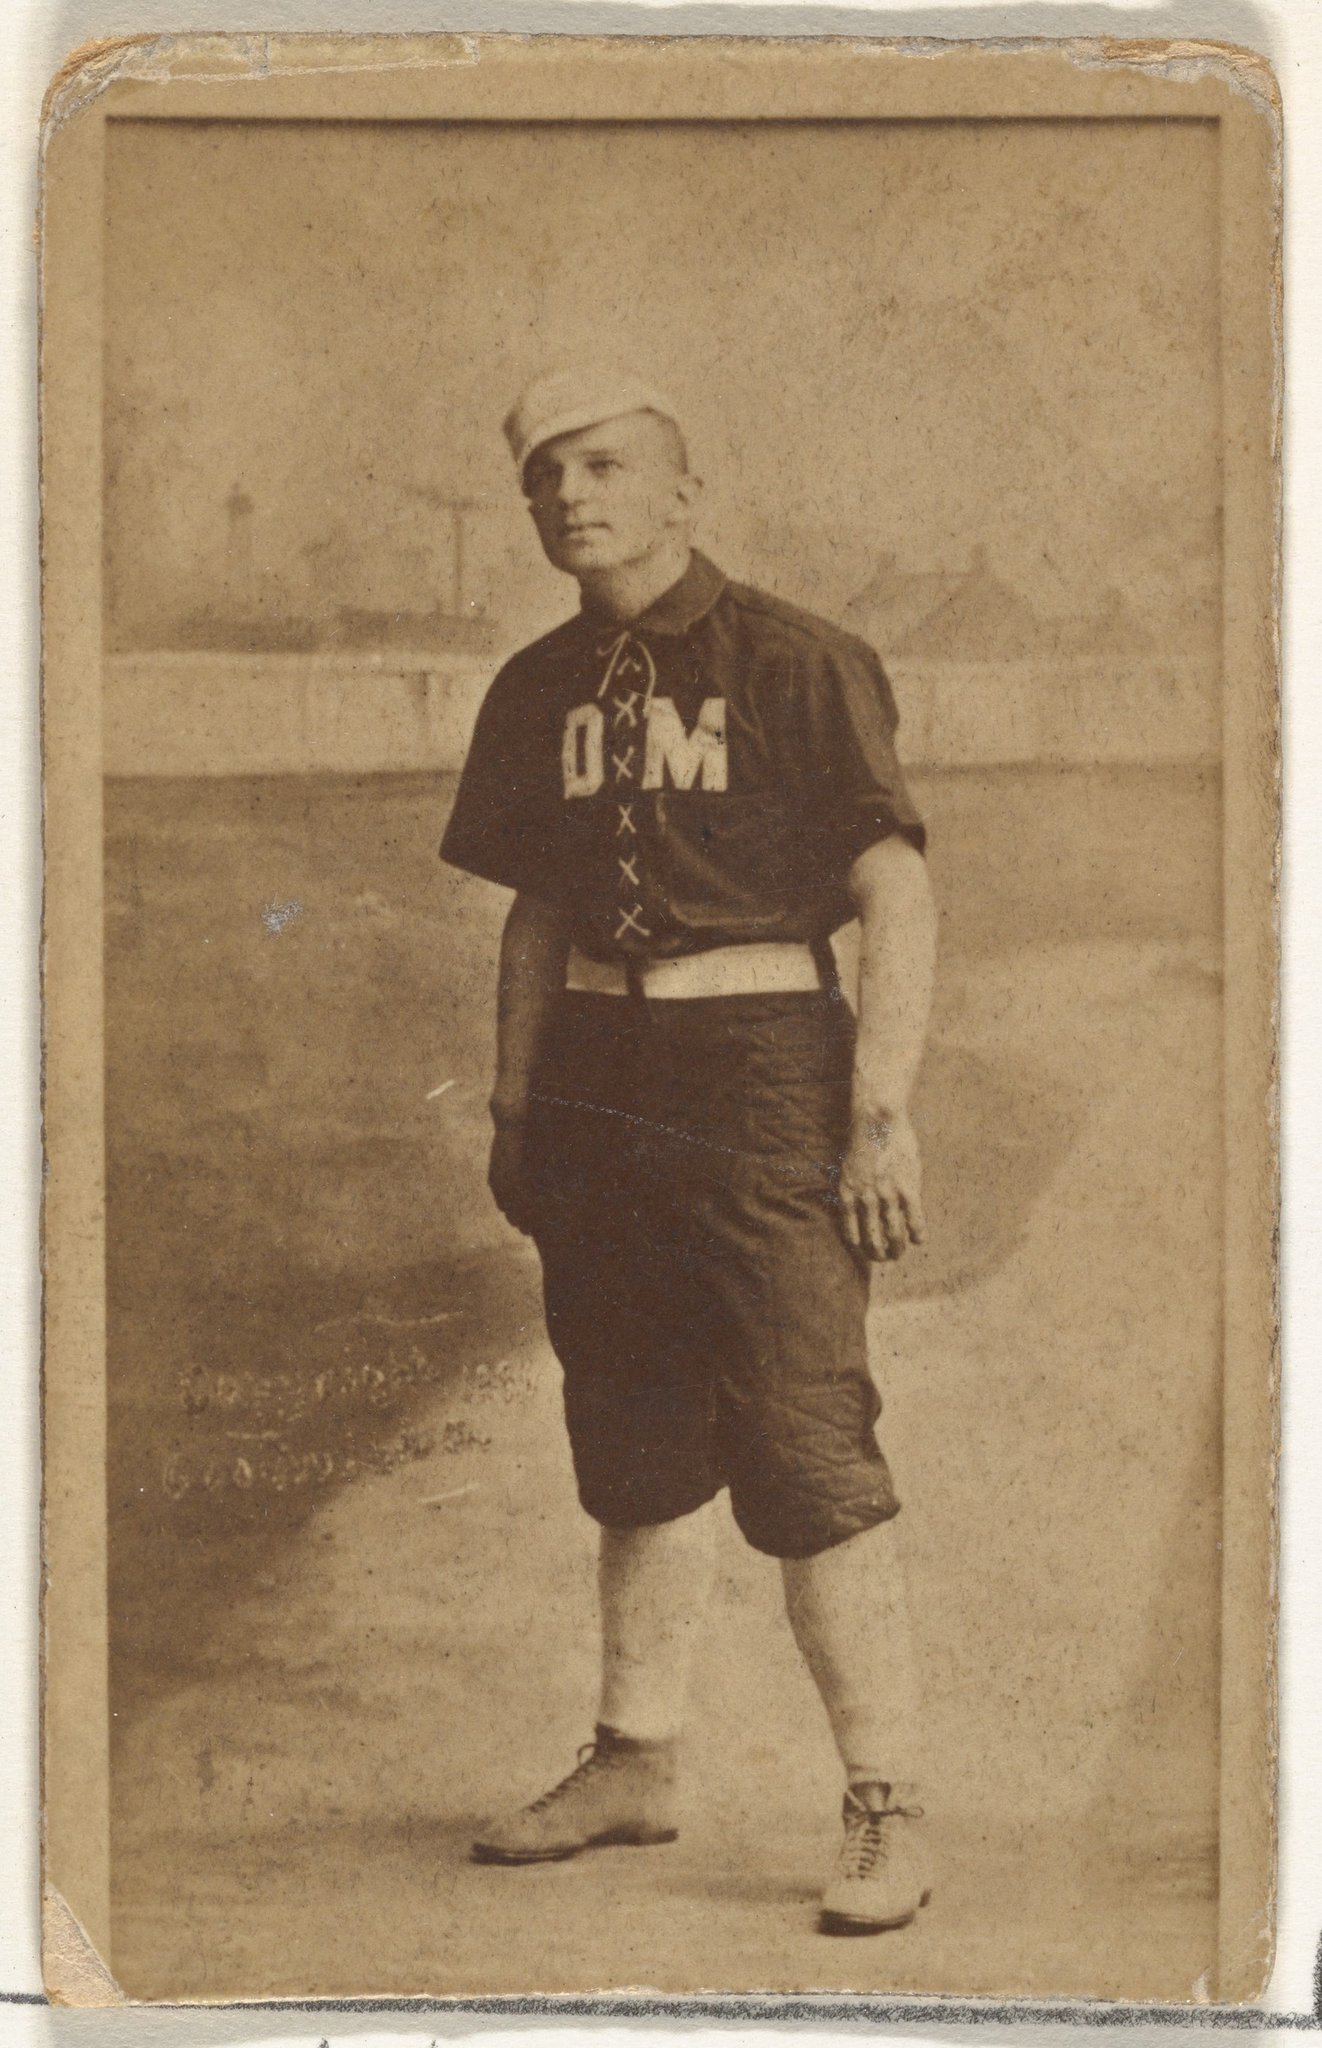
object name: baseball card, photograph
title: James Wear "Bug" Holliday, Des Moines Prohibitionists, from the Old Judge series (N172) for Old Judge Cigarettes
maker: goodwin & company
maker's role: publisher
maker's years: 1850-1950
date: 1887-1890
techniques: albumen silver print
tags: men,portraits,baseball,athletes